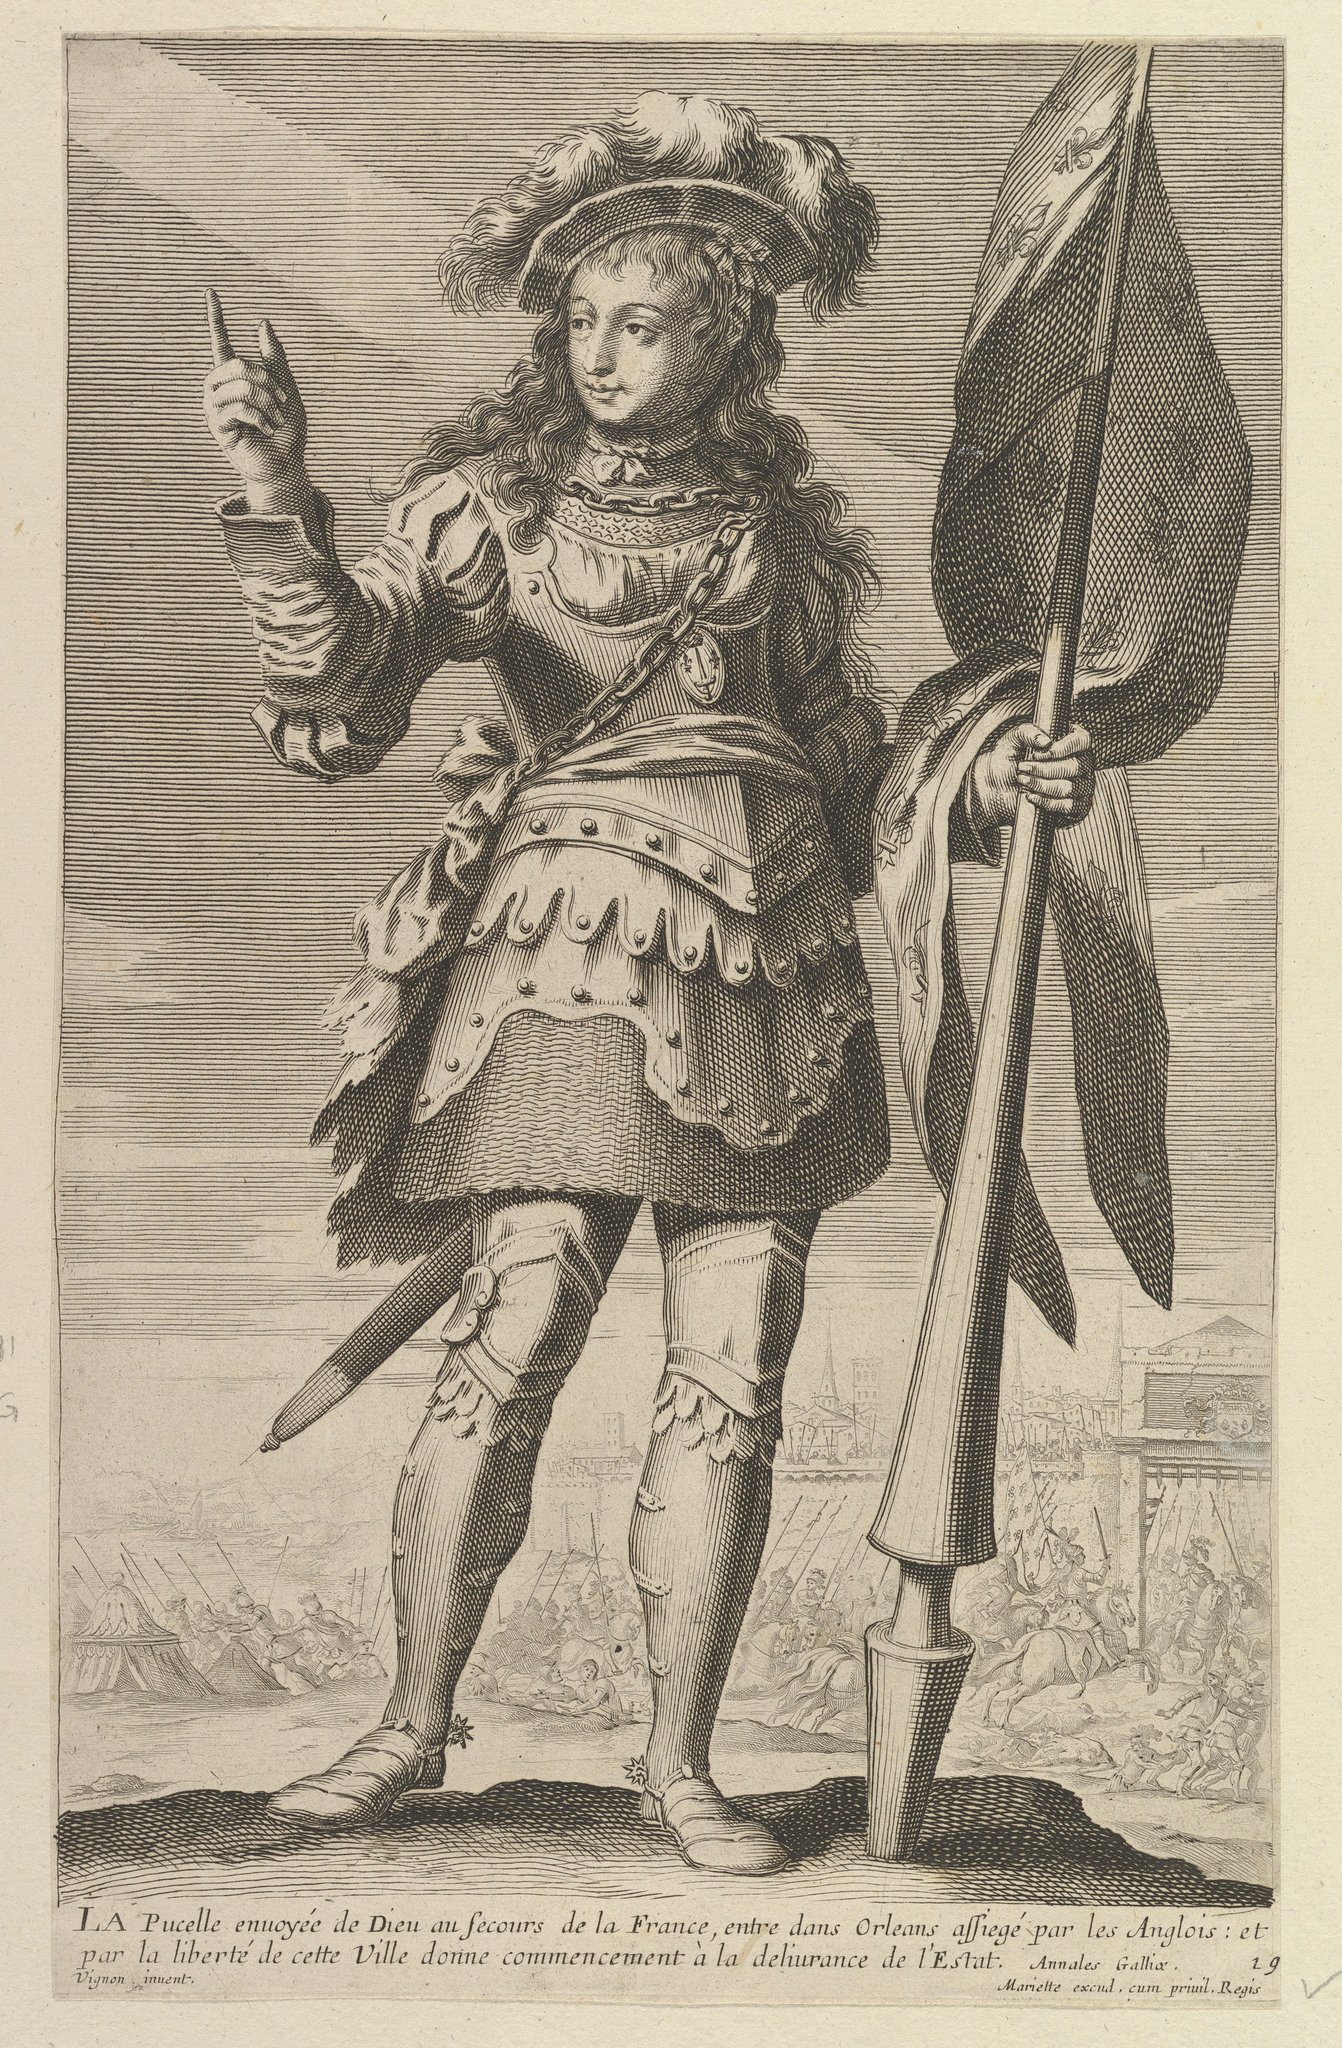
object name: print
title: La Pucelle d'Orléans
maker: gilles rousselet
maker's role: artist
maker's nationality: french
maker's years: 1614-1686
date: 1647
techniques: engraving, etching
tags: joan of arc